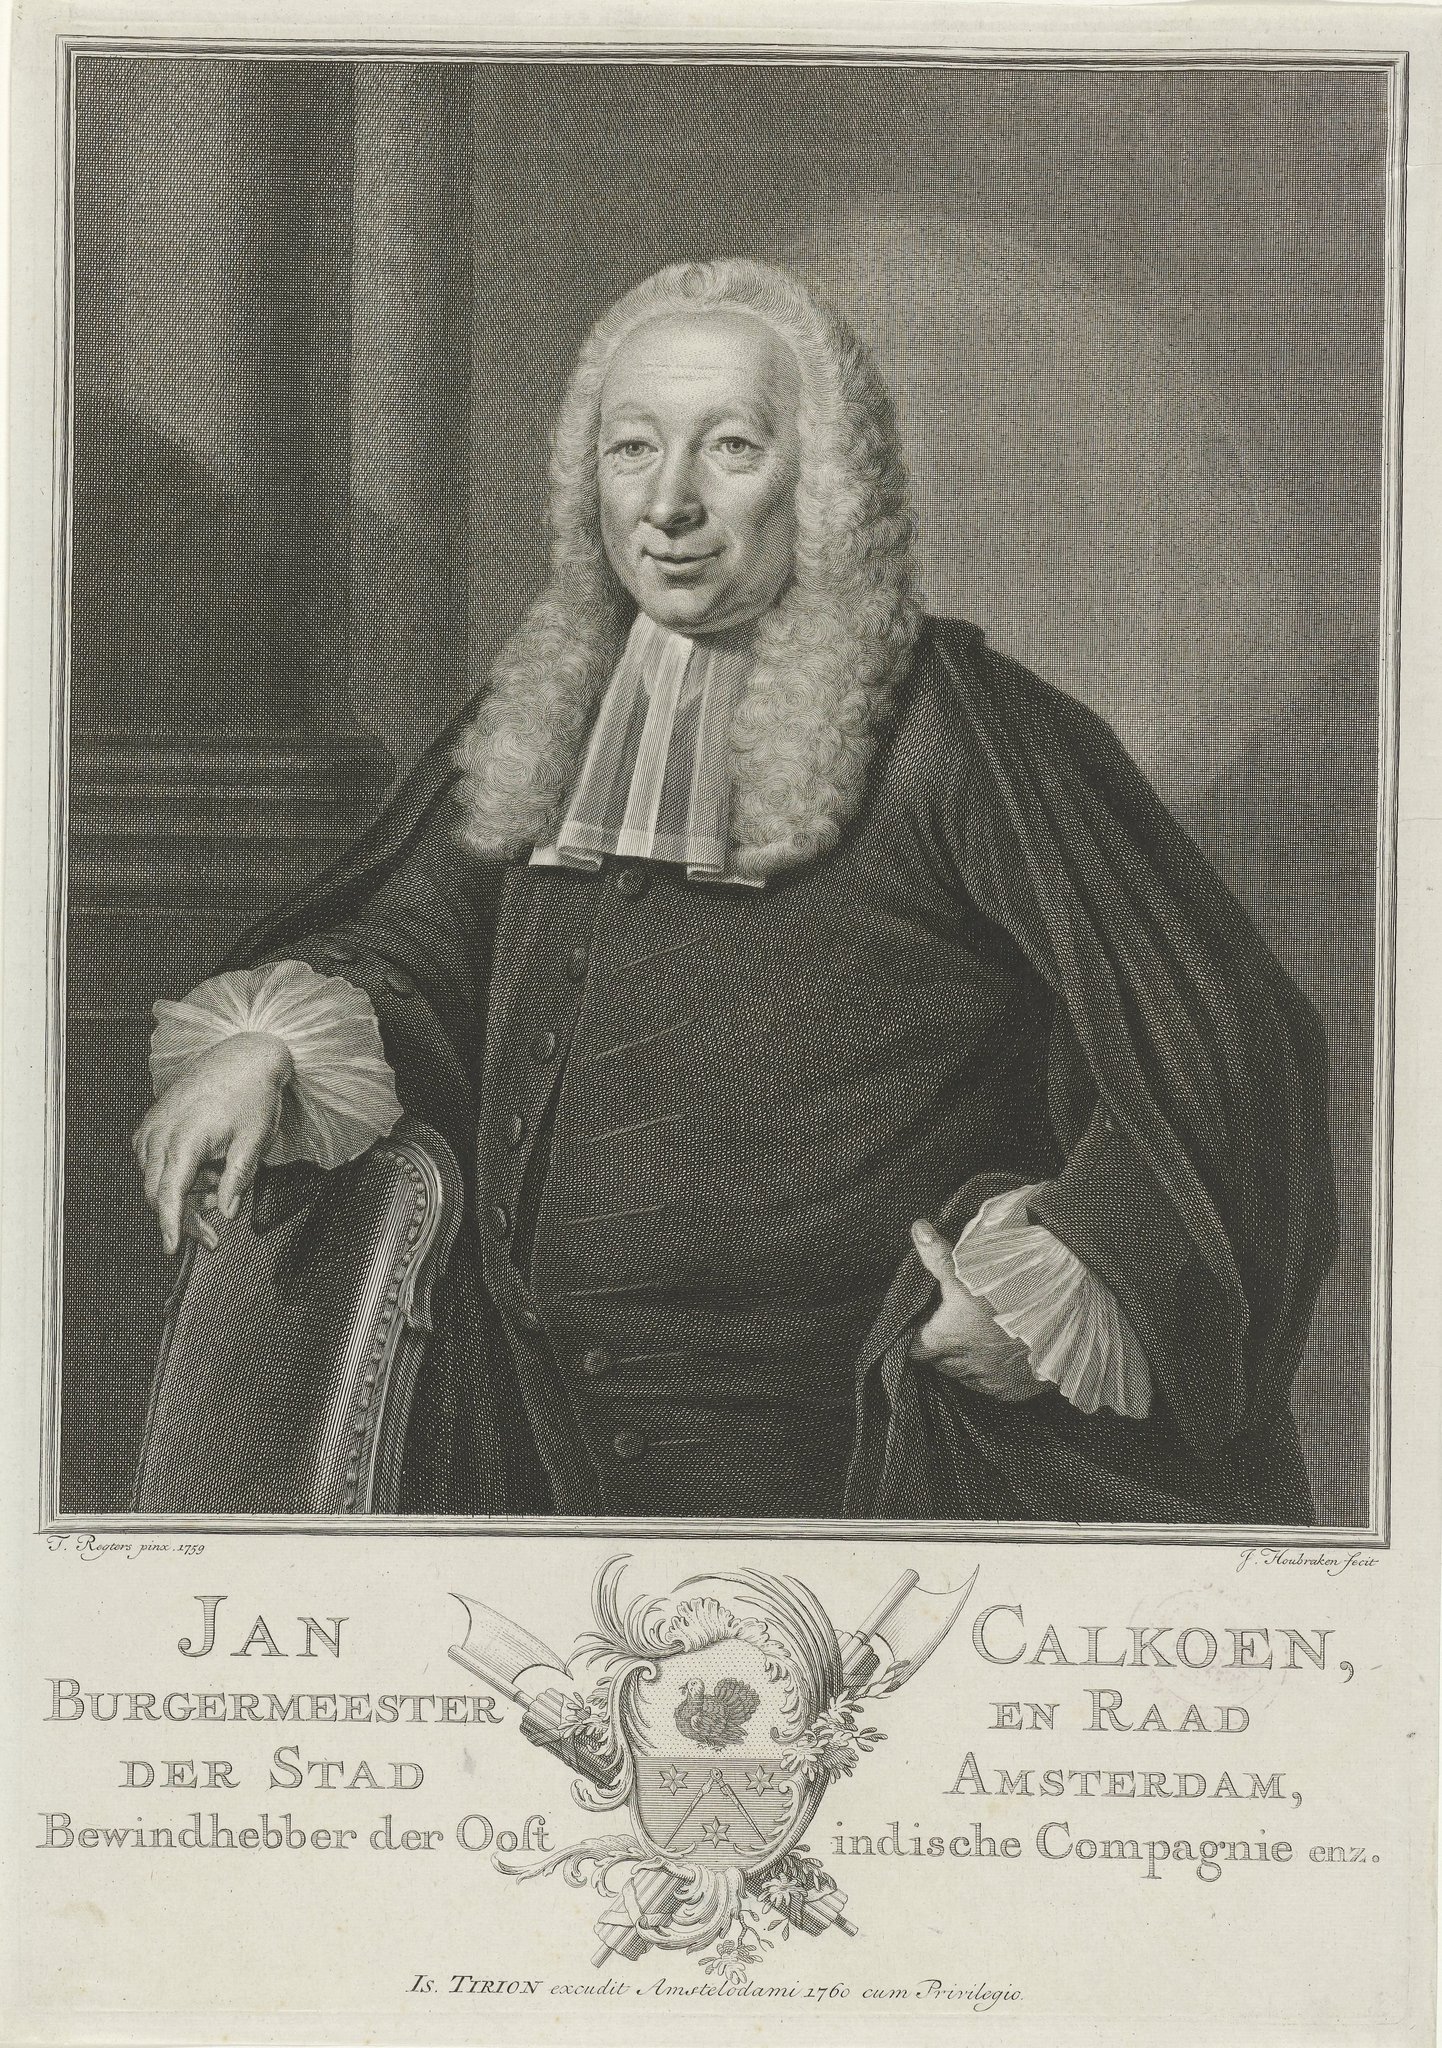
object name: print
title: Portret van Jan Calkoen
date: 1760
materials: paper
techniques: engraving, etching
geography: amsterdam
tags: mayor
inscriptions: collector's mark: Lugt 240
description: Portret ten halven lijven van Jan Calkoen, in een interieur met zuilen op de achtergrond. Zijn rechterhand leunt op de rugleuning van een stoel naast hem. Onder het portret zijn wapen en zijn naam en gegevens in vier regels in het Nederlands.